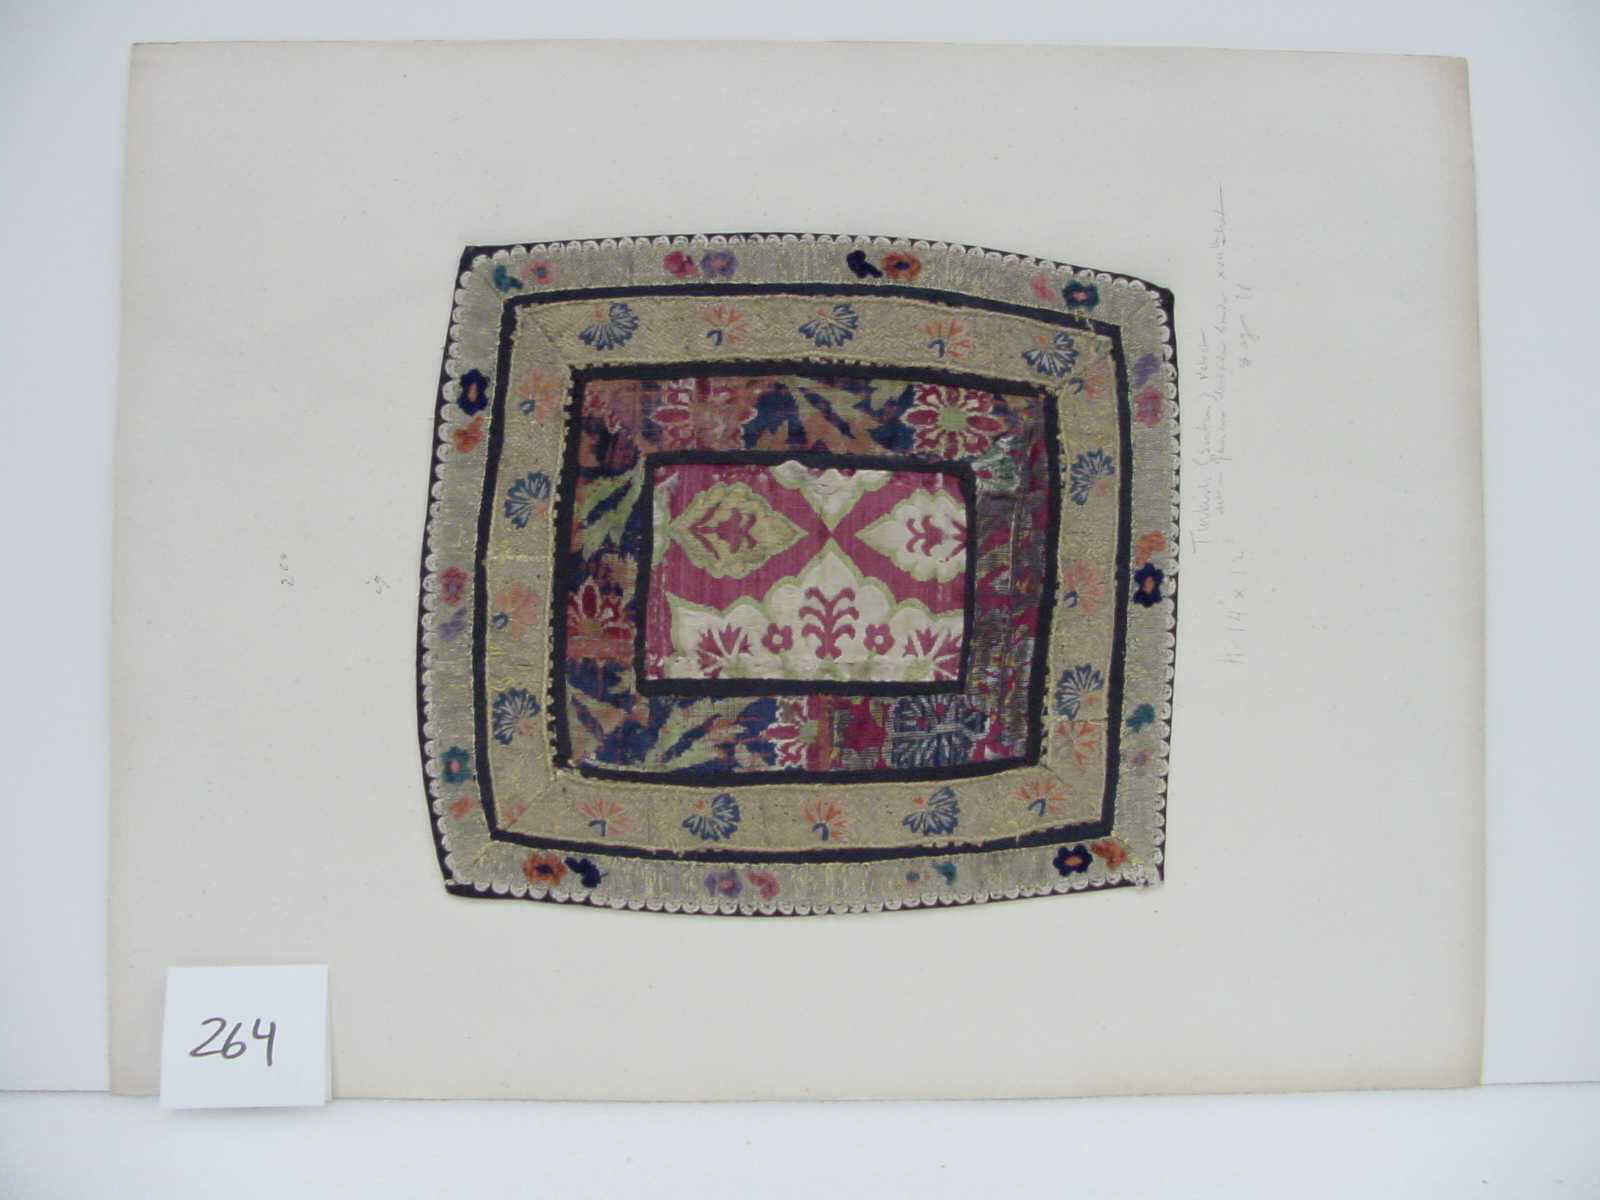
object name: textile fragment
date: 1601-1700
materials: silk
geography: turkey